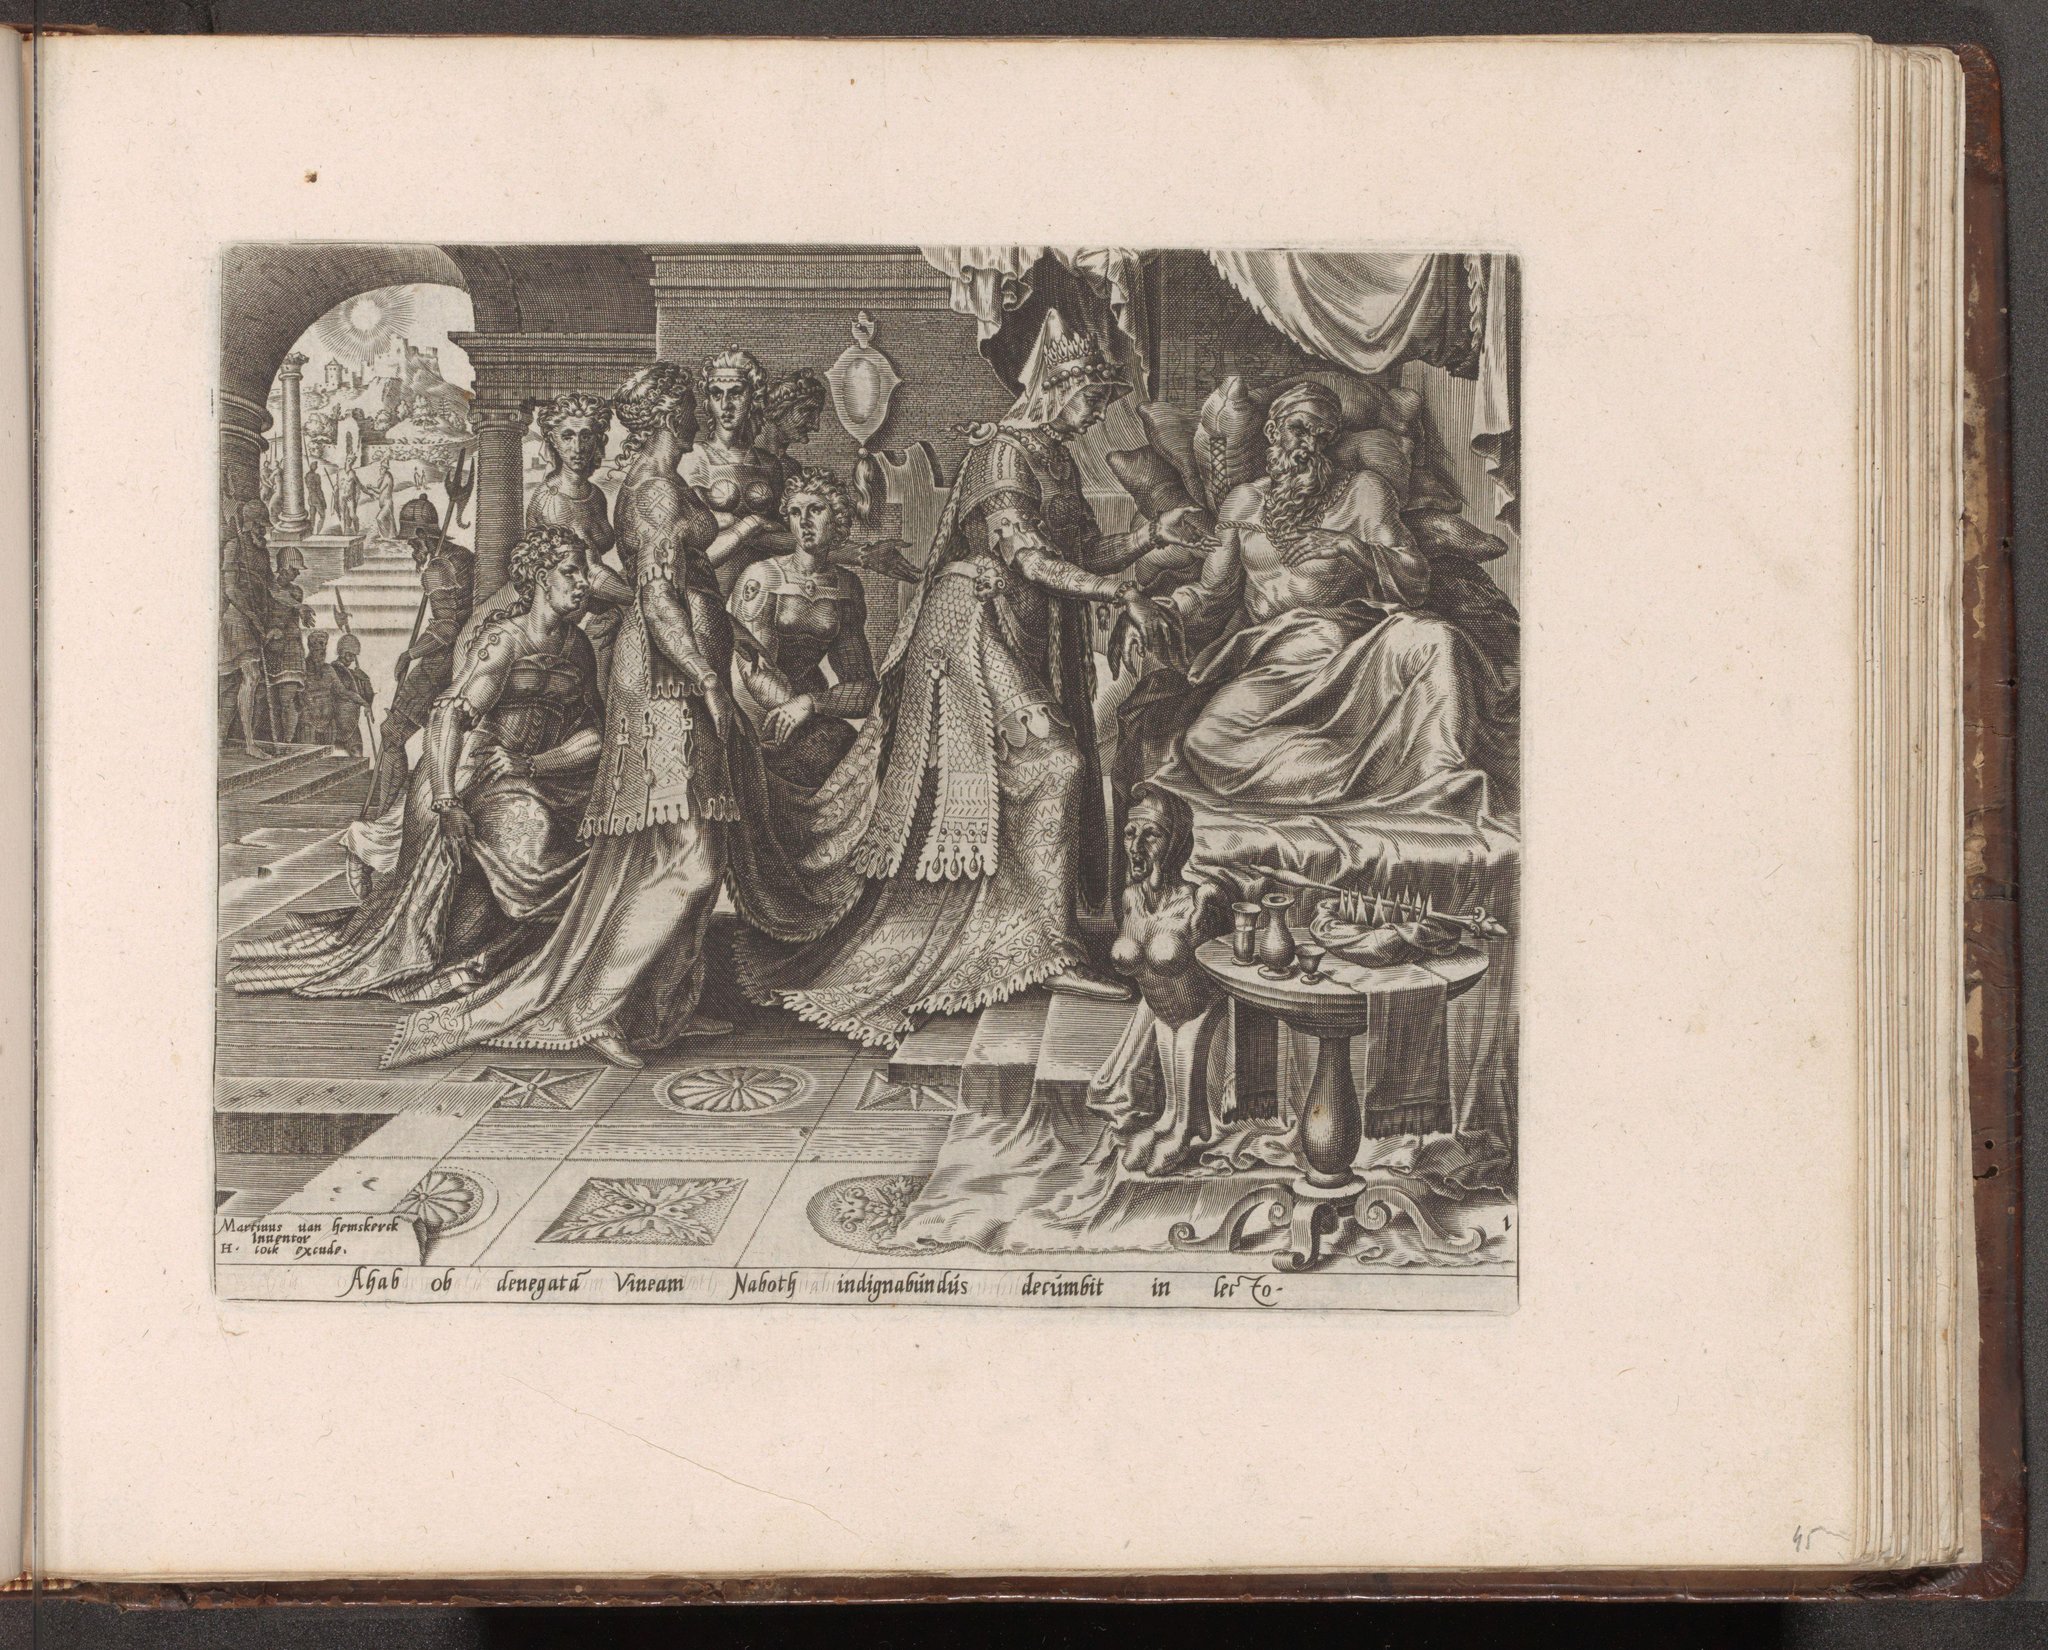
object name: print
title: Thesaurus sacrarum historiaru[m] veteris testame[n]ti, elega[n]tissimis imaginibus expressu[m] excelle[n]tissimoru[m] in hac arte viroru[m] opera: nu[n]c primu[m] in luce[m] editus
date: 1559-1563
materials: paper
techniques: engraving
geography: antwerp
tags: ahab becomes depressed, lies down on his bed, faces the wall and refuses to eat ~ naboth's vineyard, naboth refuses to sell his vineyard to ahab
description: Koning Achab ligt teleurgesteld op bed omdat Nabot weigert hem zijn wijngaard te verkopen. Zijn vrouw Izebel staat naast het bed en belooft hem dat ze ervoor zal zorgen dat hij Nabots wijngaard krijgt. Achter Izebel staat een groepje dienaressen en in de deuropening paleiswachten. Links op de achtergrond een voorstelling van wat vooraf ging: koning Achab vraagt Nabot zijn wijngaard af te staan. Onder de voorstelling een vers in het Latijn. Prent maakt deel uit van een album.